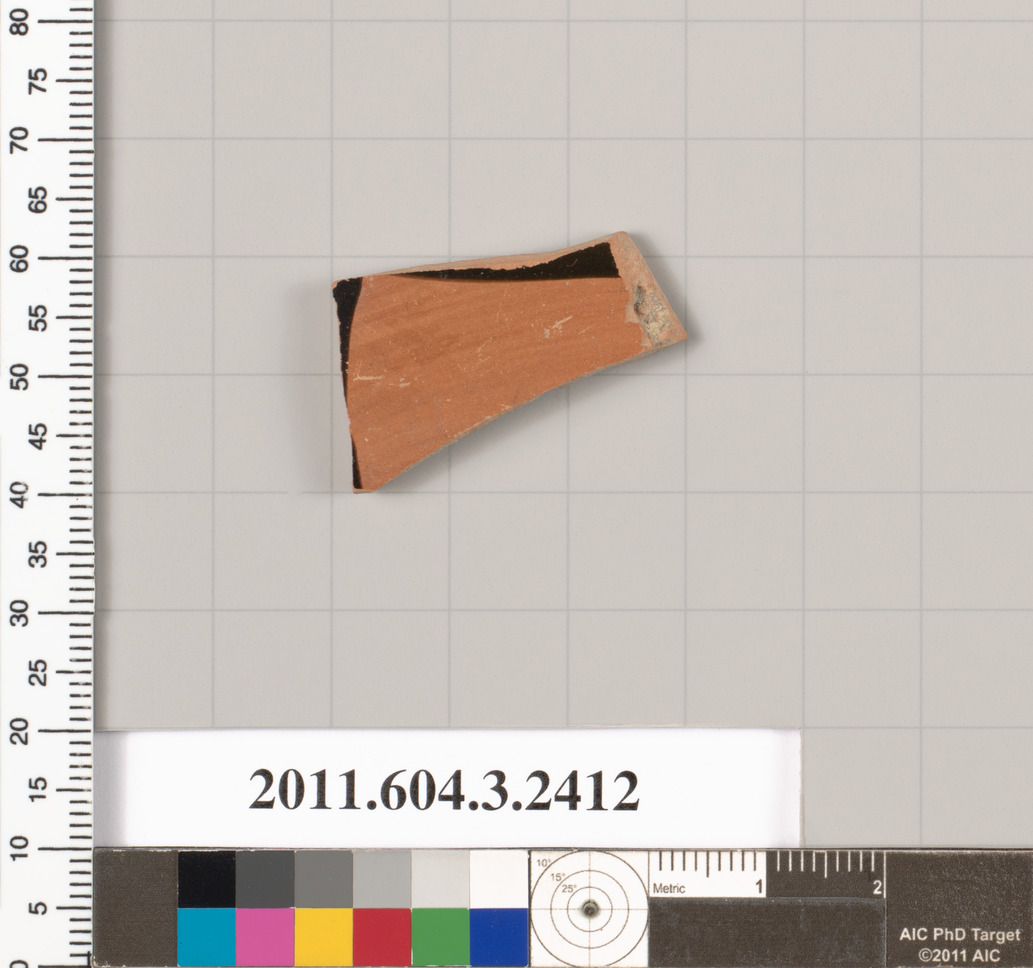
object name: kylix fragment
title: Terracotta fragment of a kylix: eye-cup (drinking cup)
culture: greek, attic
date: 530-510 BCE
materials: terracotta